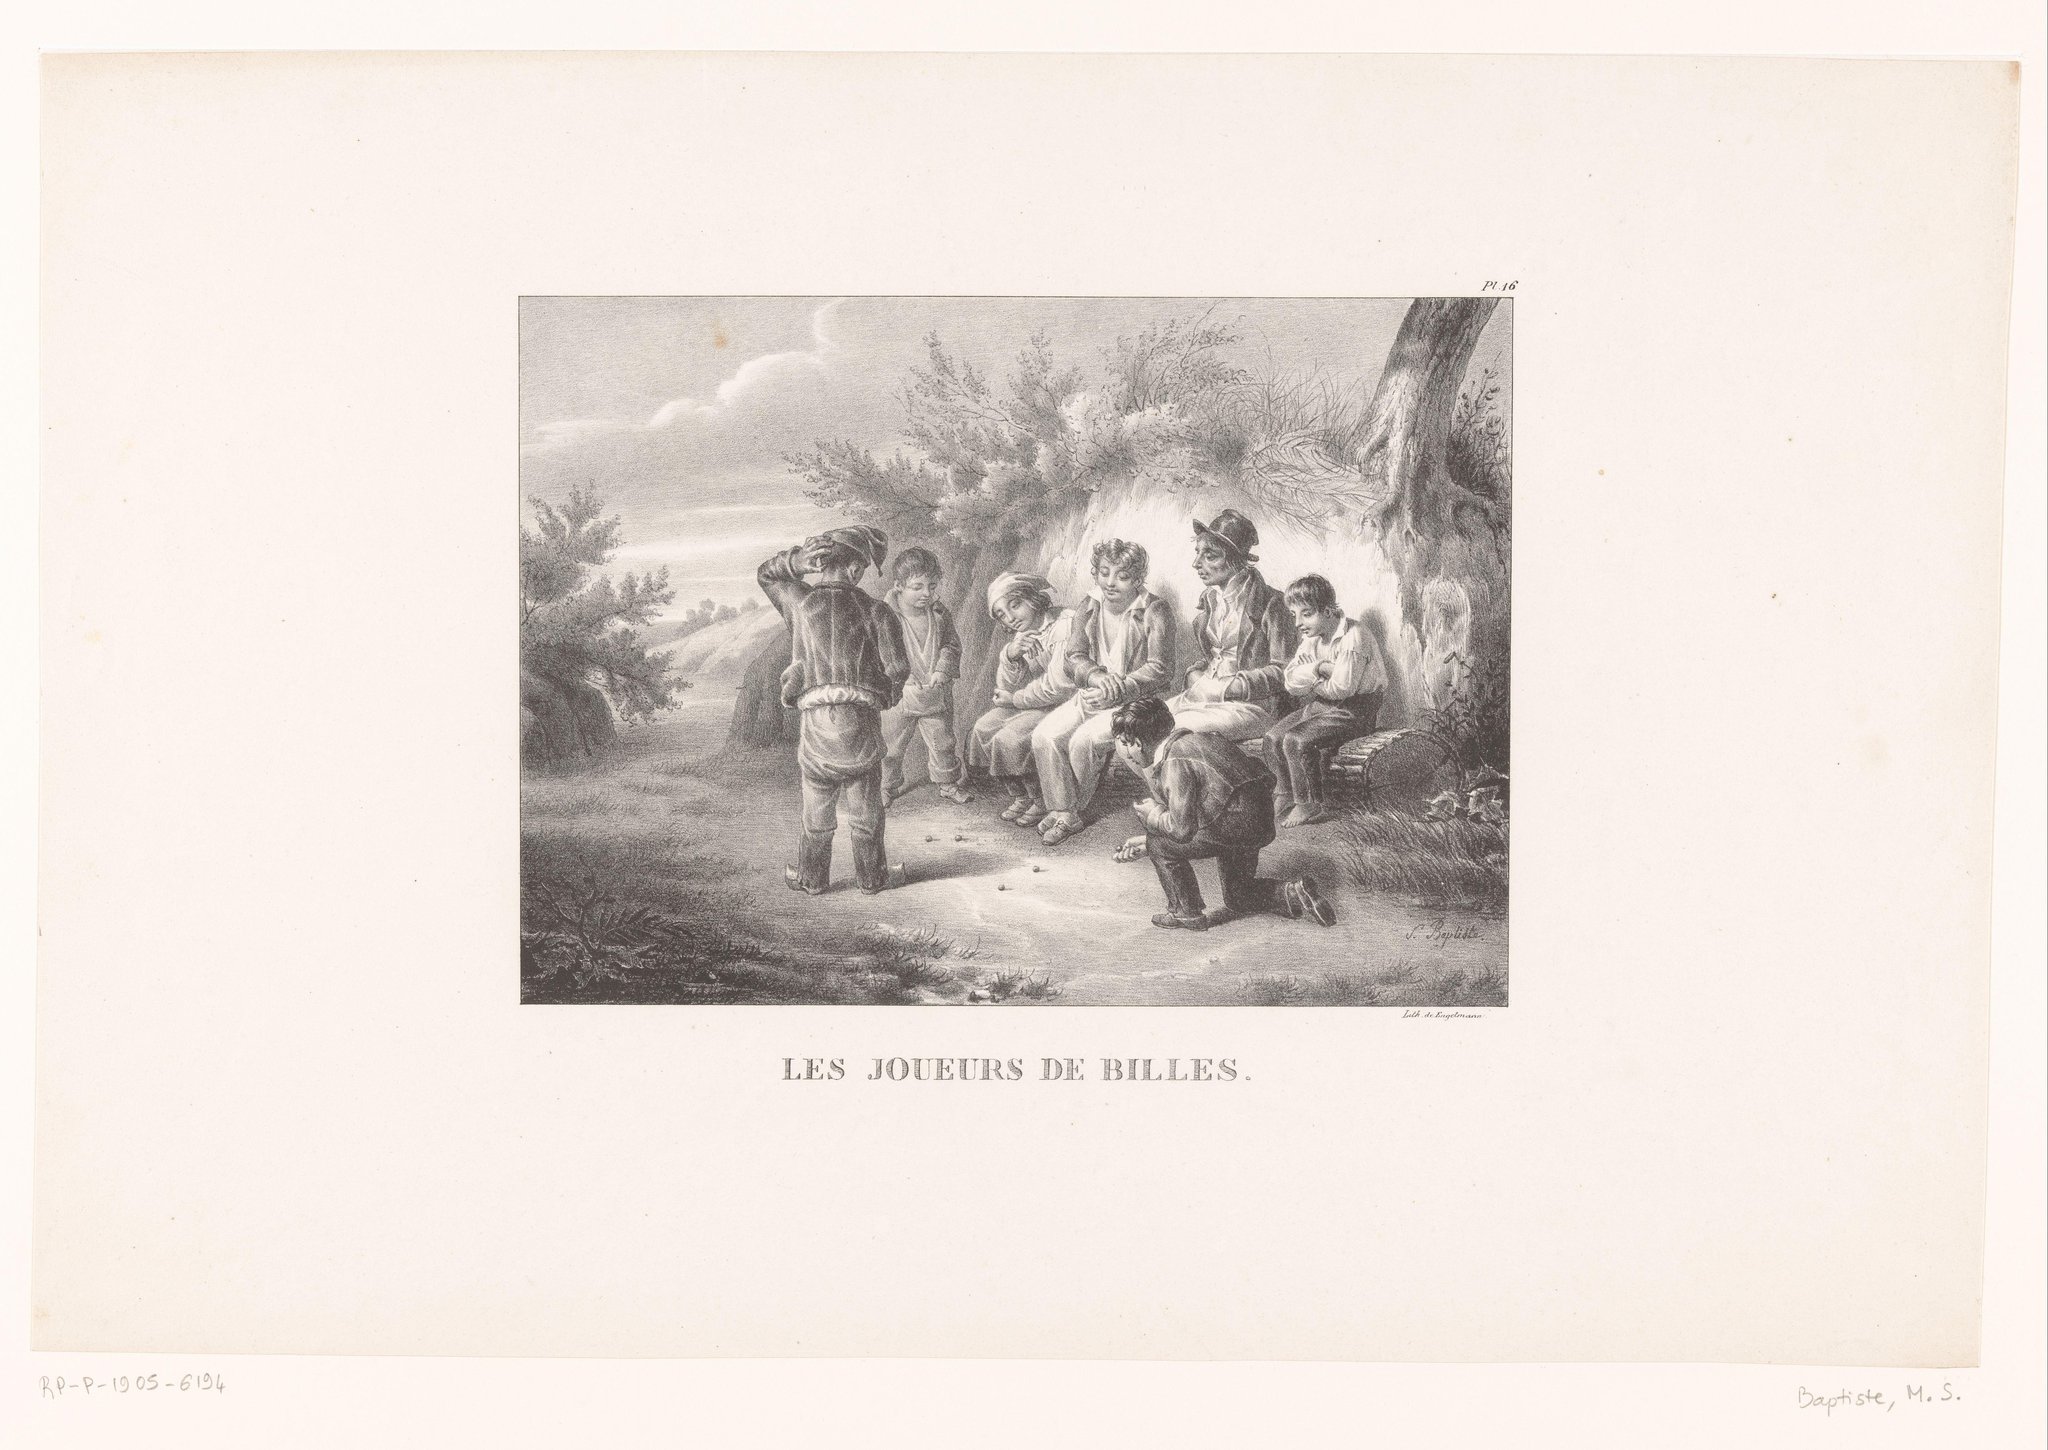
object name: print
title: Straatverkopers, kinderen en bedelaars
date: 1829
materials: paper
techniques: lithograph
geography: paris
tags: children's games and plays, (playing at) marbles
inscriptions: collector's mark: Lugt 2228a